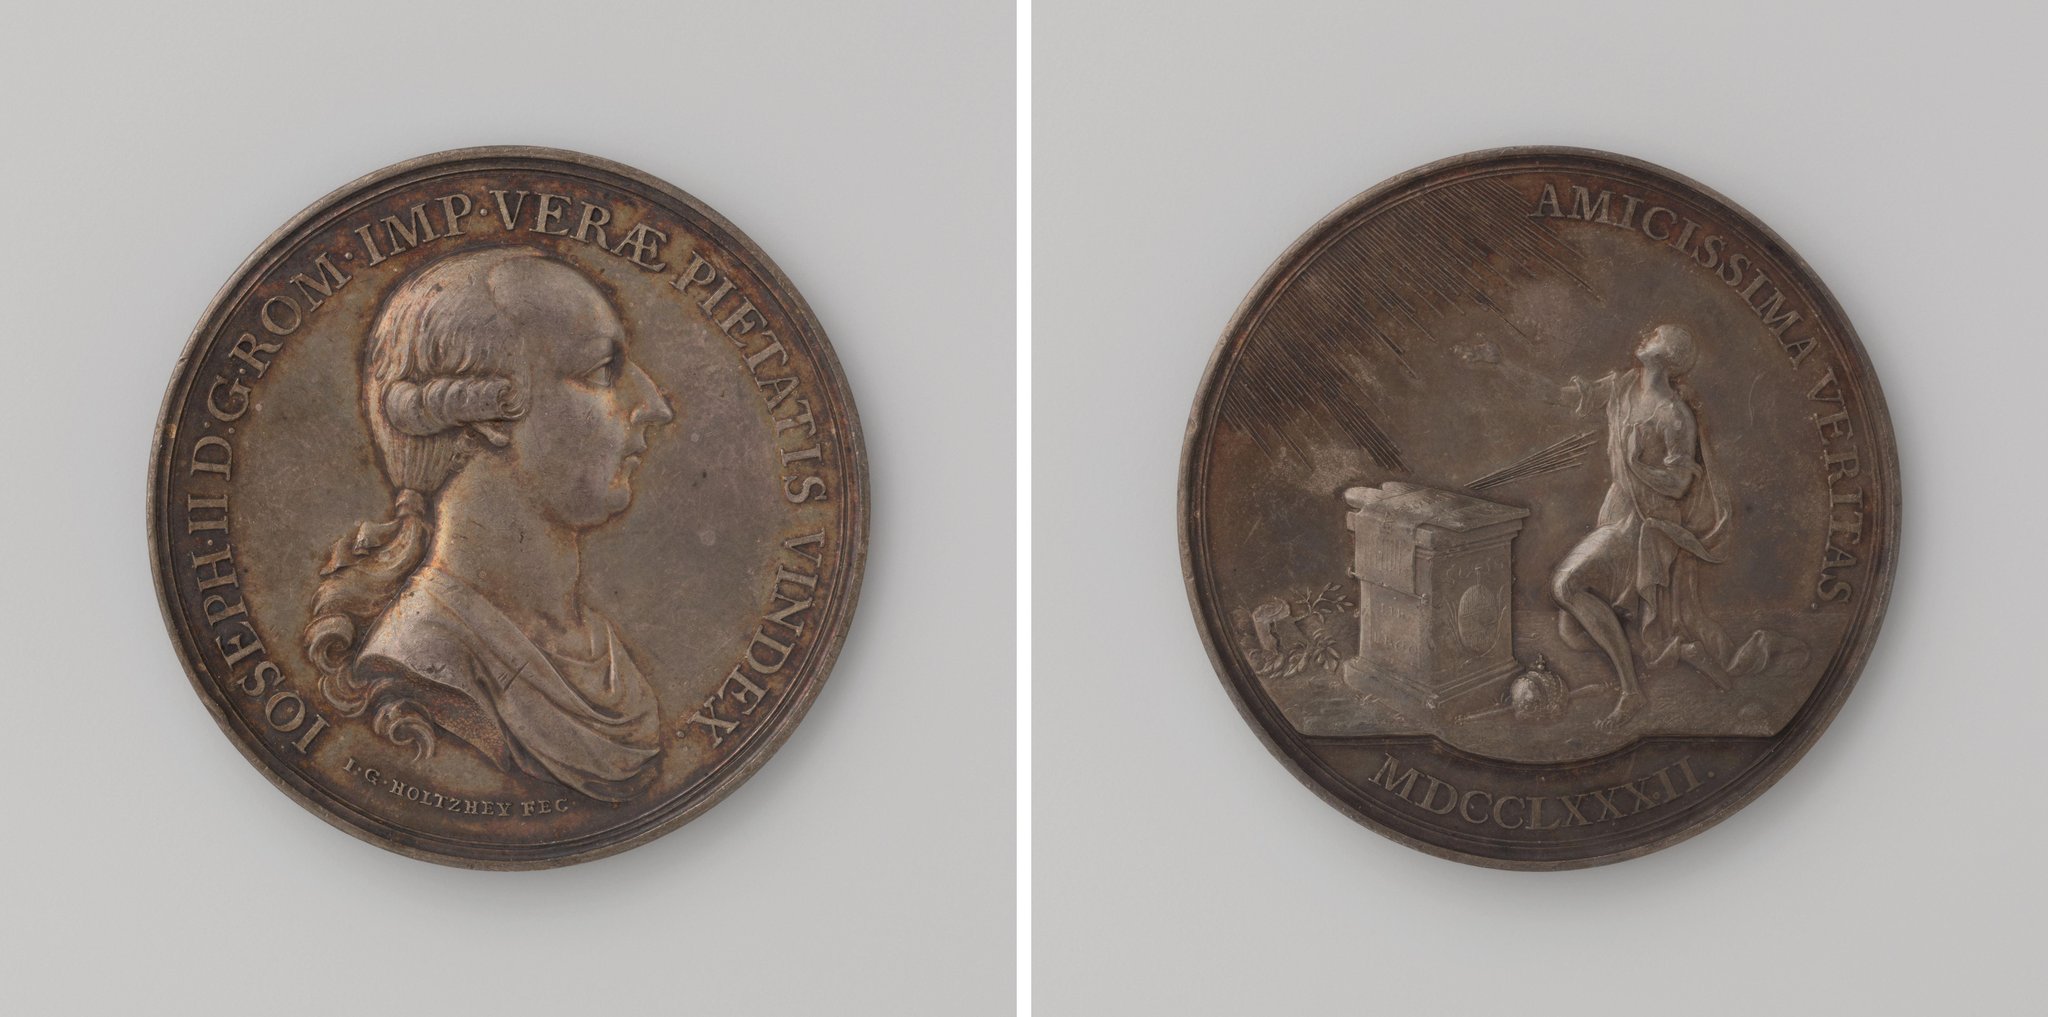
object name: history medal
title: Religieuze tollerantie van Jozef II, Duits keizer en opheffing der kloosters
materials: silver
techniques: striking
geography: amsterdam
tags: vienna, jozef ii (duits keizer)